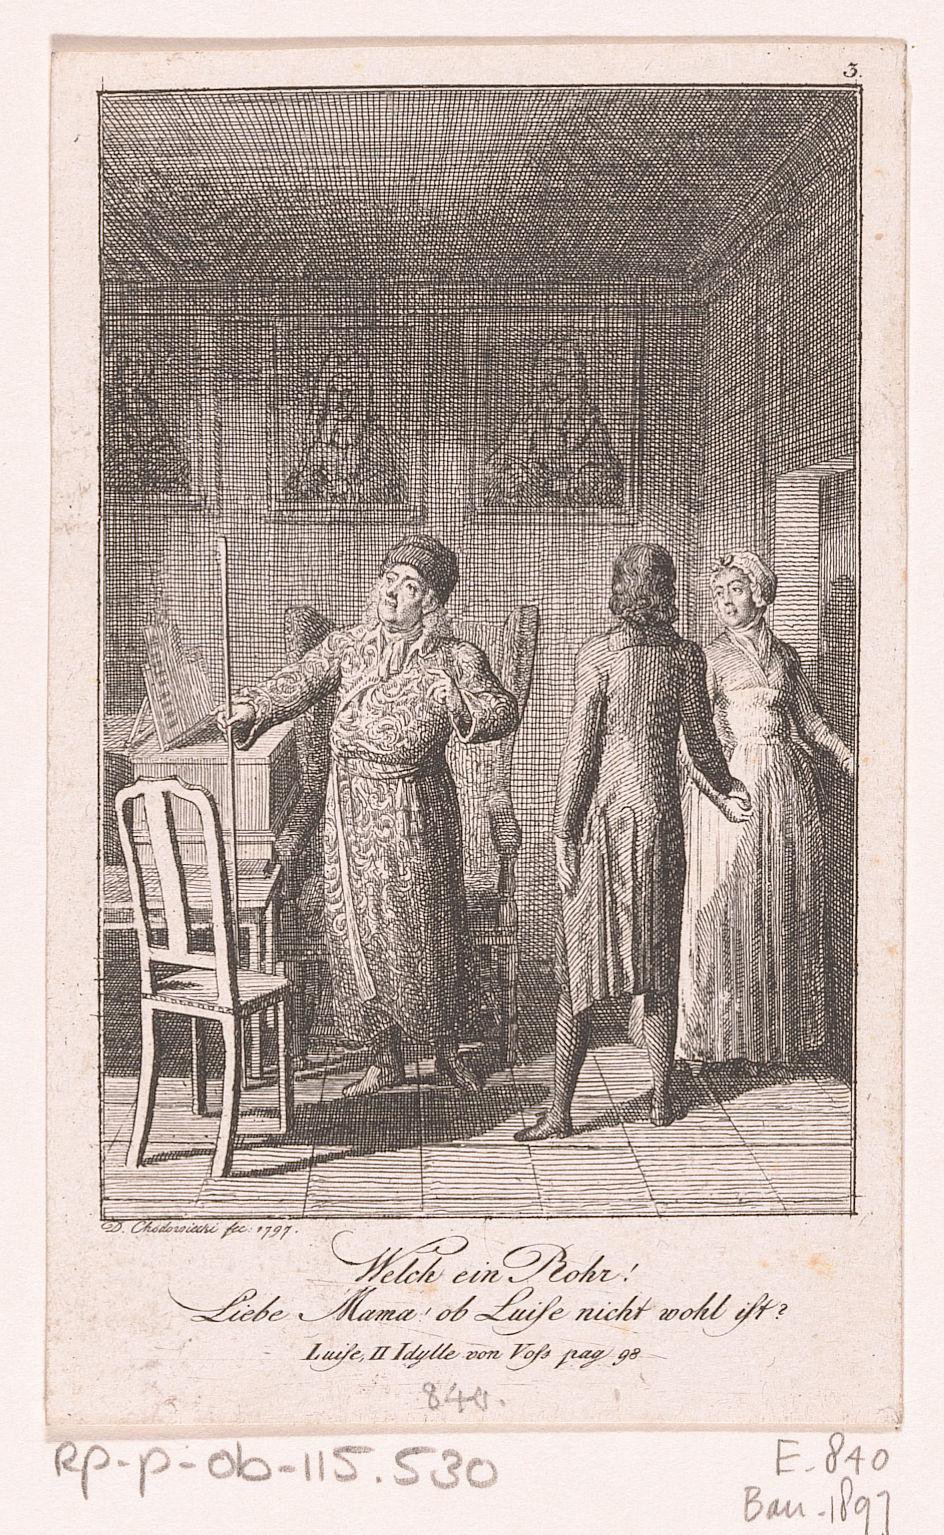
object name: print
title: Walter vraagt zijn schoonmoeder waar Luise is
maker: daniel nikolaus chodowiecki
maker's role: draughtsman, print maker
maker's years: 1726-1801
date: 1797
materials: paper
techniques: etching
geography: berlin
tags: literature, pipe ~ tobacco, living-room, parlour, sitting-room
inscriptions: collector's mark: Lugt 2228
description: Prent gebruikt voor: Becker, Wilhelm Gottlieb. Almanach und Taschenbuch zum geselligen Vergnügen von W. G. Becker für 1798. Leipzig: Voss und Comp., [1797].